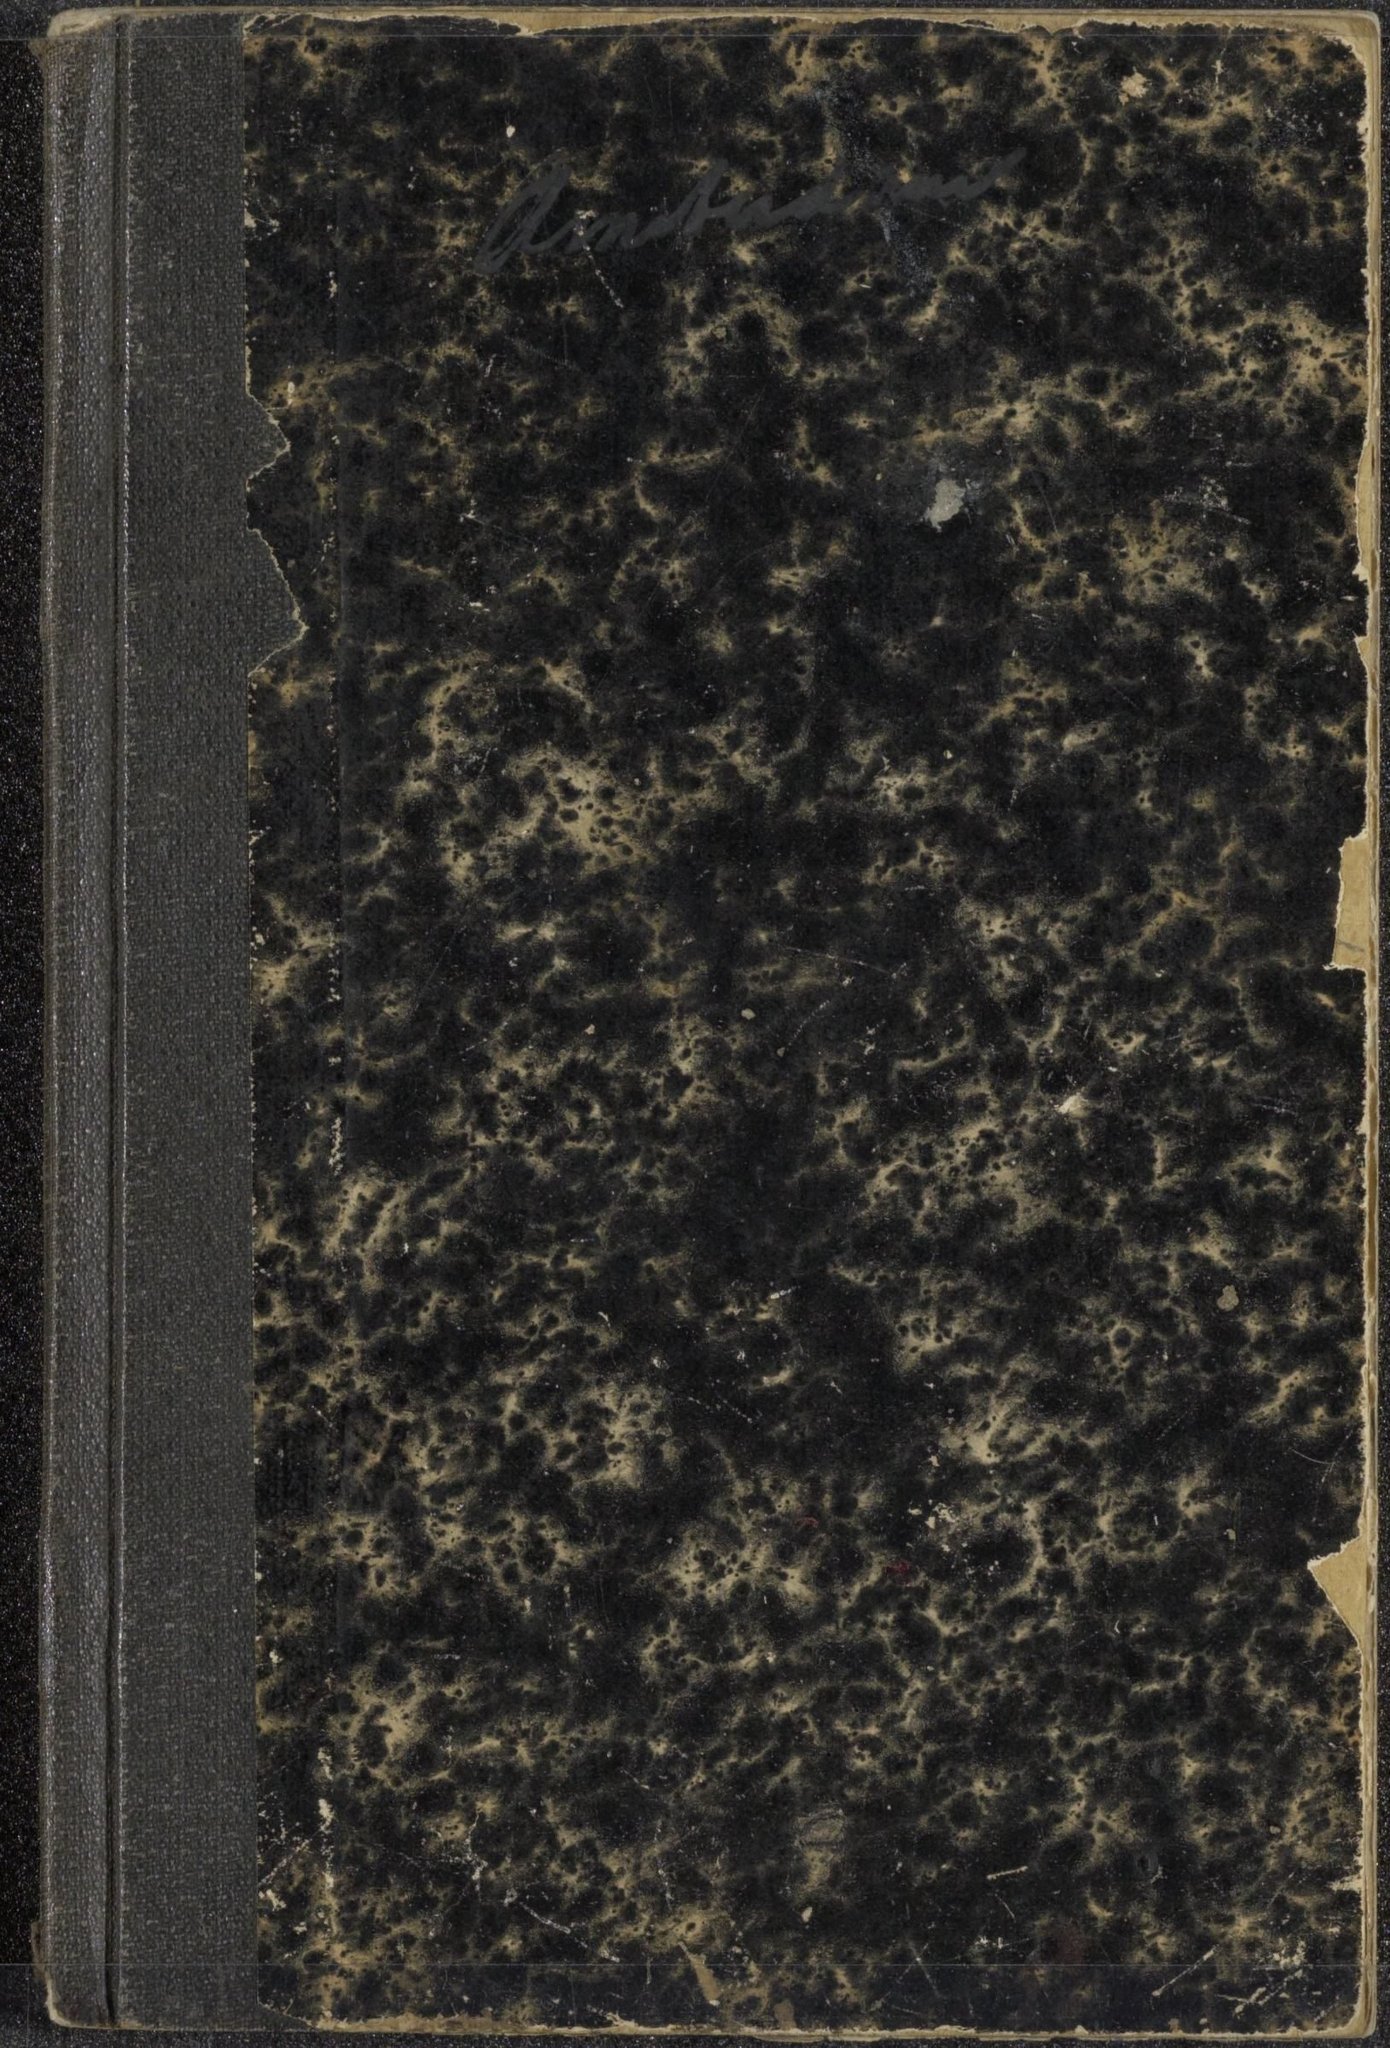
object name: sketchbook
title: Schetsboek met 20 bladen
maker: george hendrik breitner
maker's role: draughtsman, painter, print maker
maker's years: 1857-1923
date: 1886-1895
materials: cardboard, chalk, linen, paper, pencil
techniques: marbling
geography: amsterdam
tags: cat, street, dog, amsterdam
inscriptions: annotation: ‘Amsterdam’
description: Schetsboek met 20 bladen met figuurstudies, gezichten te Amsterdam, honden en katten.